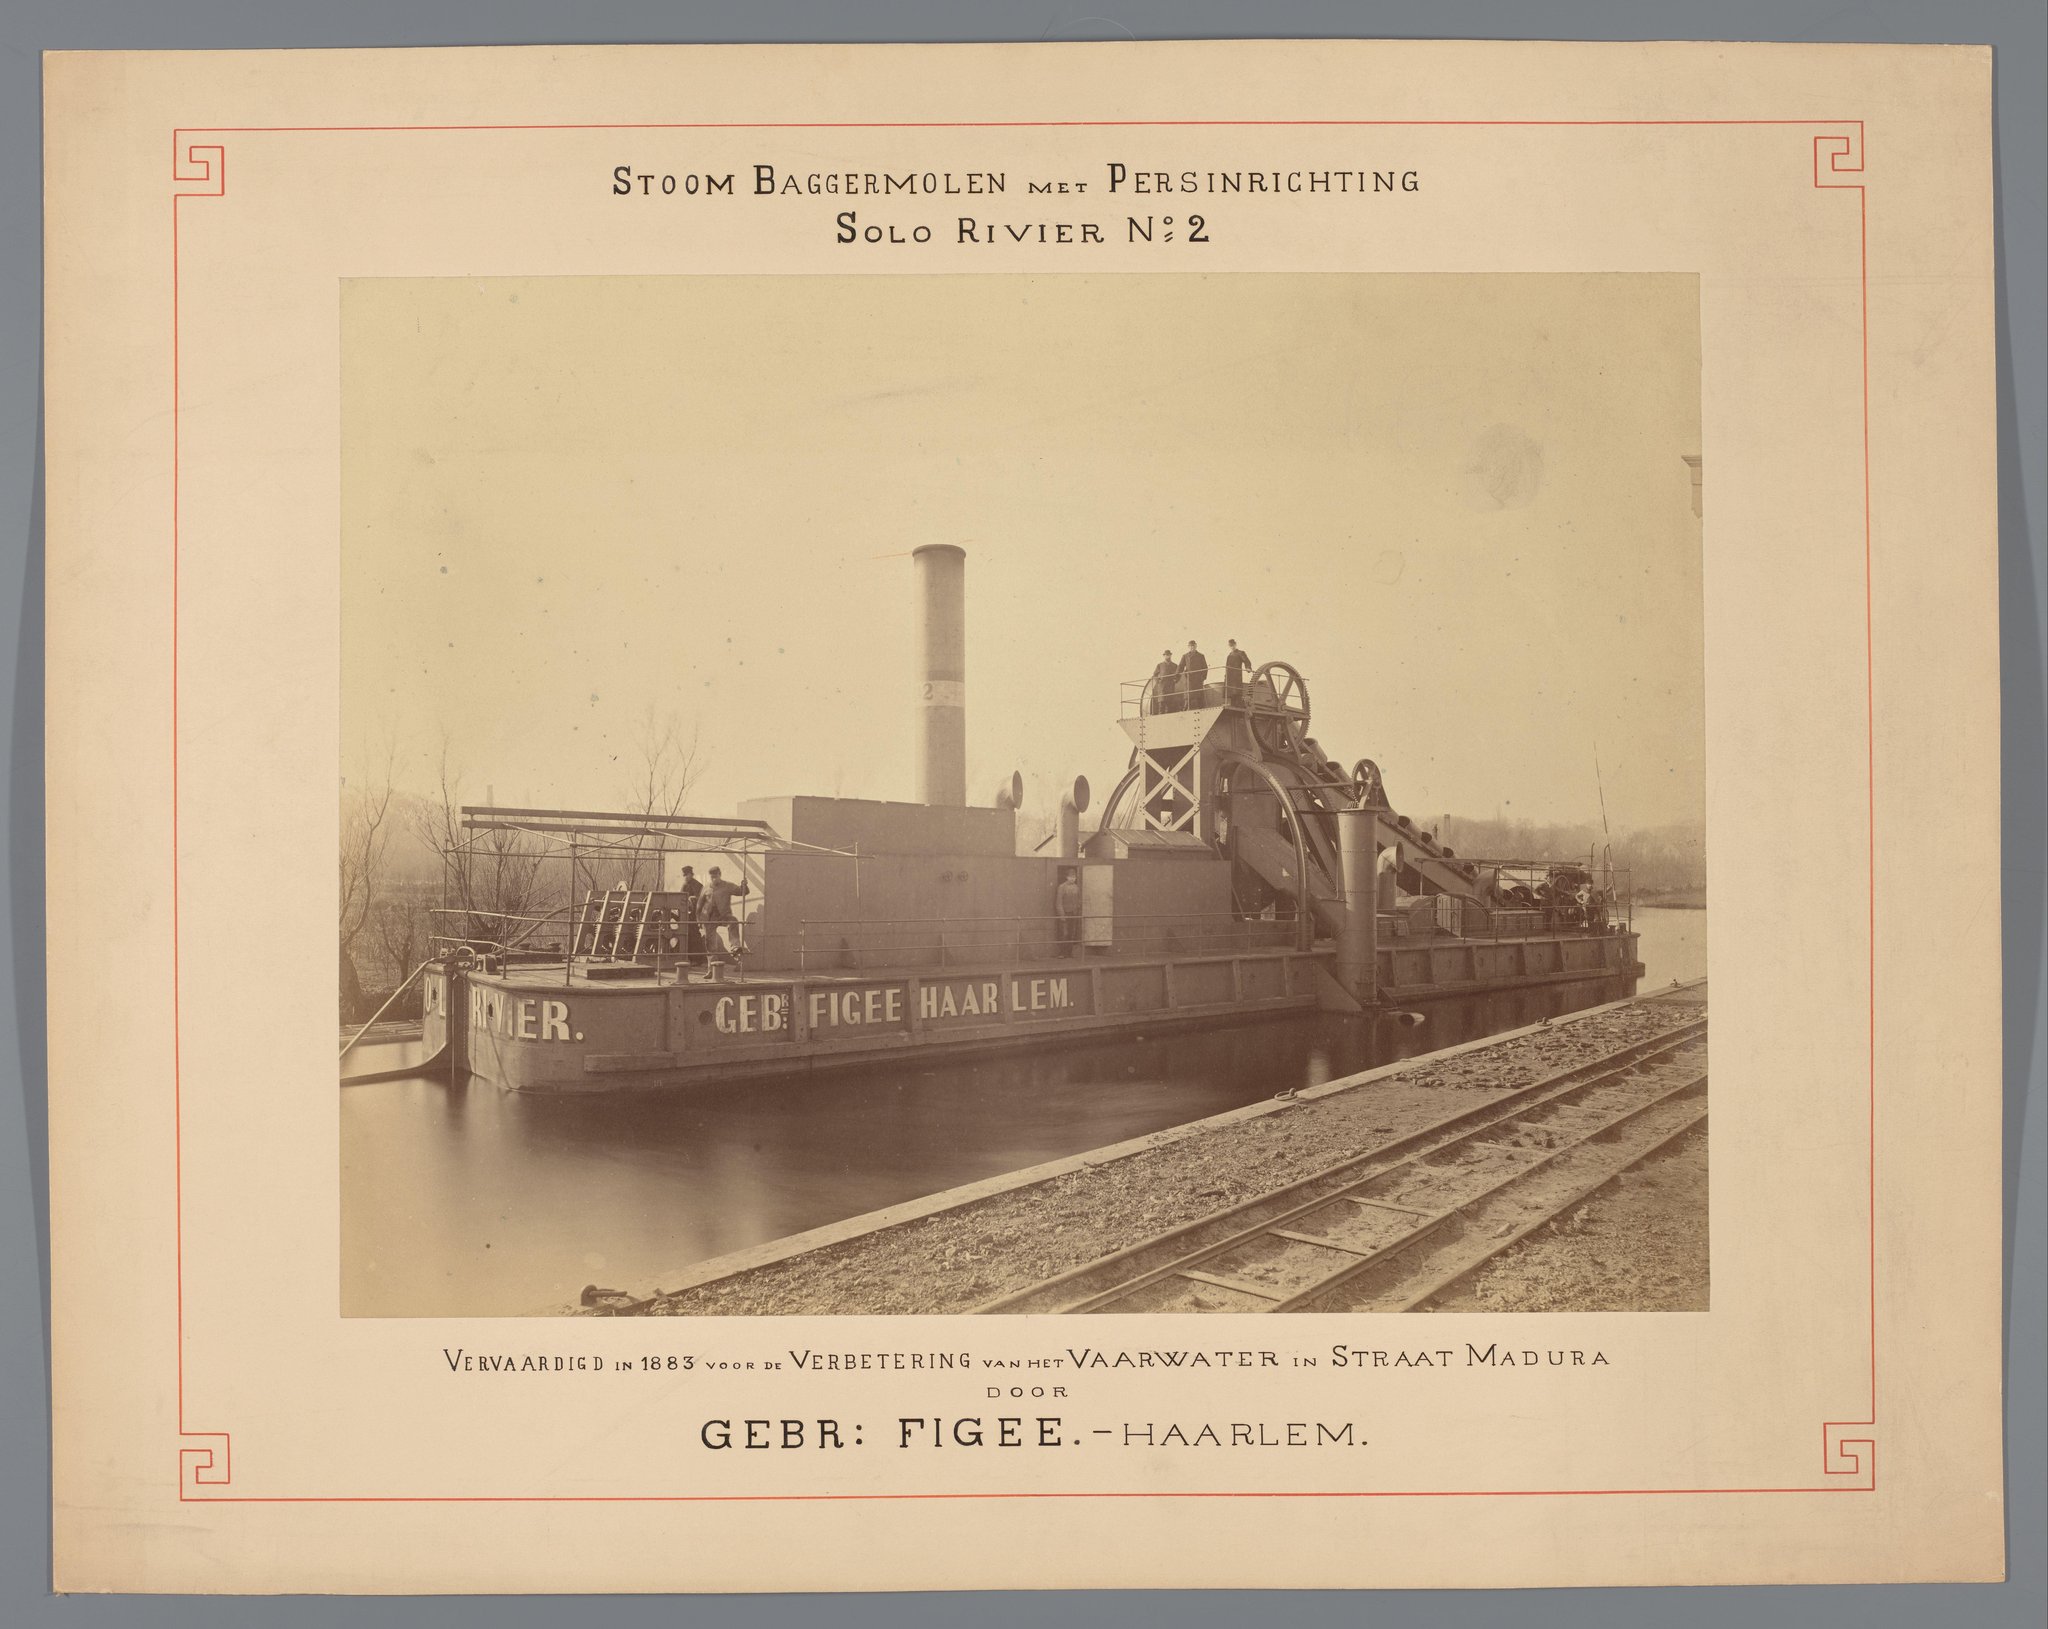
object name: photograph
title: Stoombaggermolen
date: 1883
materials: cardboard, paper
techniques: photography, printing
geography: haarlem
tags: haarlem, indonesia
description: Foto van een baggermolen, op karton geplakt, in rood gelijnd kader met tekst onder en boven waarop de opdrachtgever e.d. staat. Vervaardigd voor vaarwater straat Madura. Opschrift; b. en o.: 'Gebr. Figee - Haarlem - Holland'.